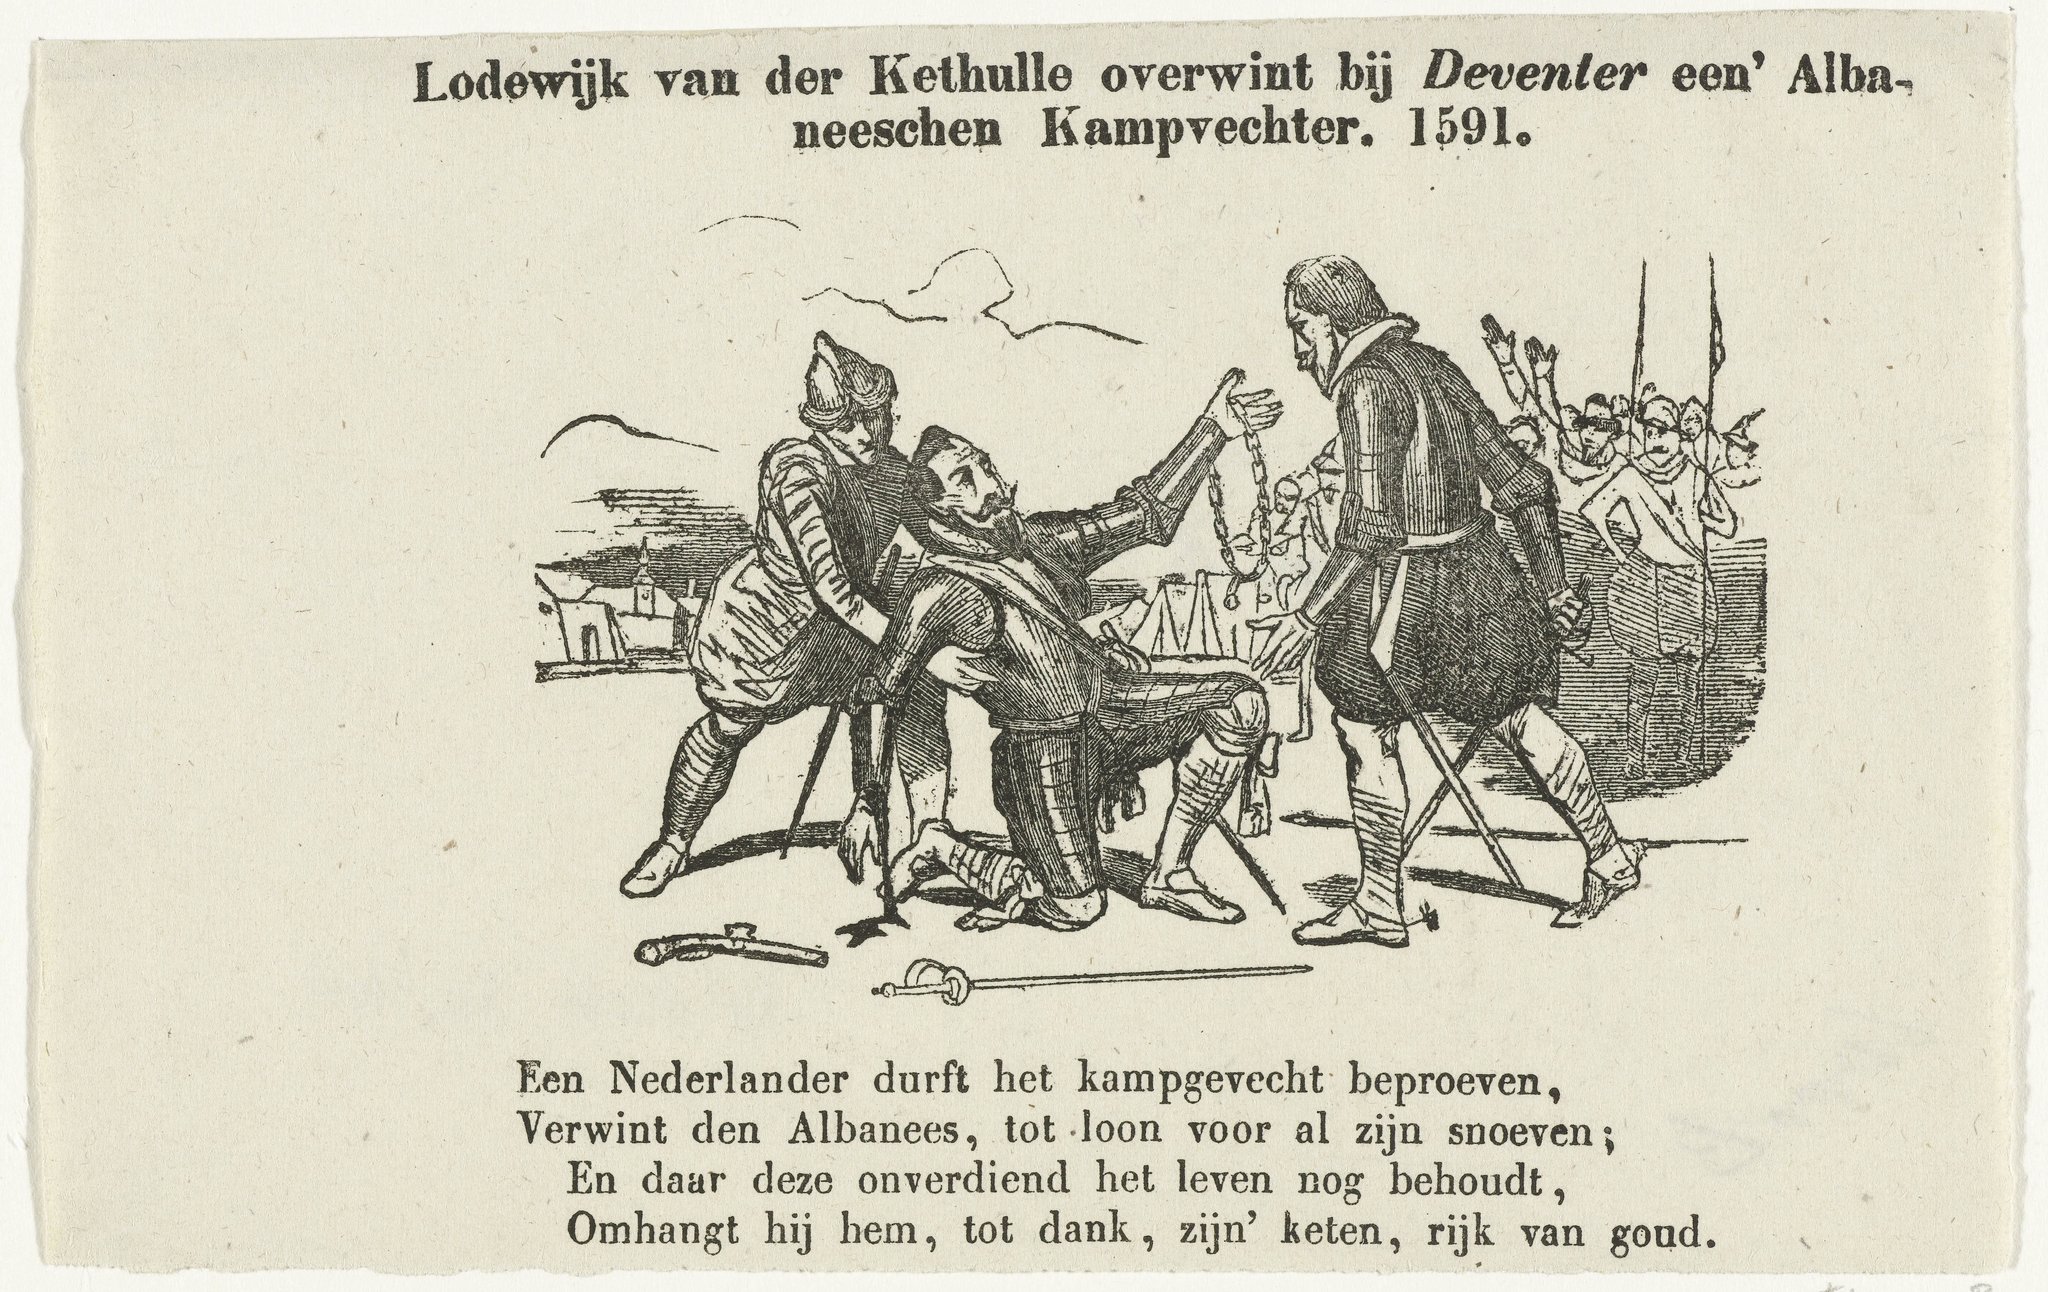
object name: history print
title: Lodewijk van der Kethulle verslaat de Spaanse ruiter, 1591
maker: Anonymous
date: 1800-1899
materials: paper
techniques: letterpress printing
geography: netherlands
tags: duelling, deventer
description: Lodewijk van der Kethulle, heer van Ryhove, verslaat de Spaanse ruiter (de Albanees, uit het leger van Alva) in een tweegevecht, buiten Deventer, 1591. De verslagen Spanjaard geeft de overwinnaar zijn gouden ketting. Onder de voorstelling een vers van 4 regels in het Nederlands.